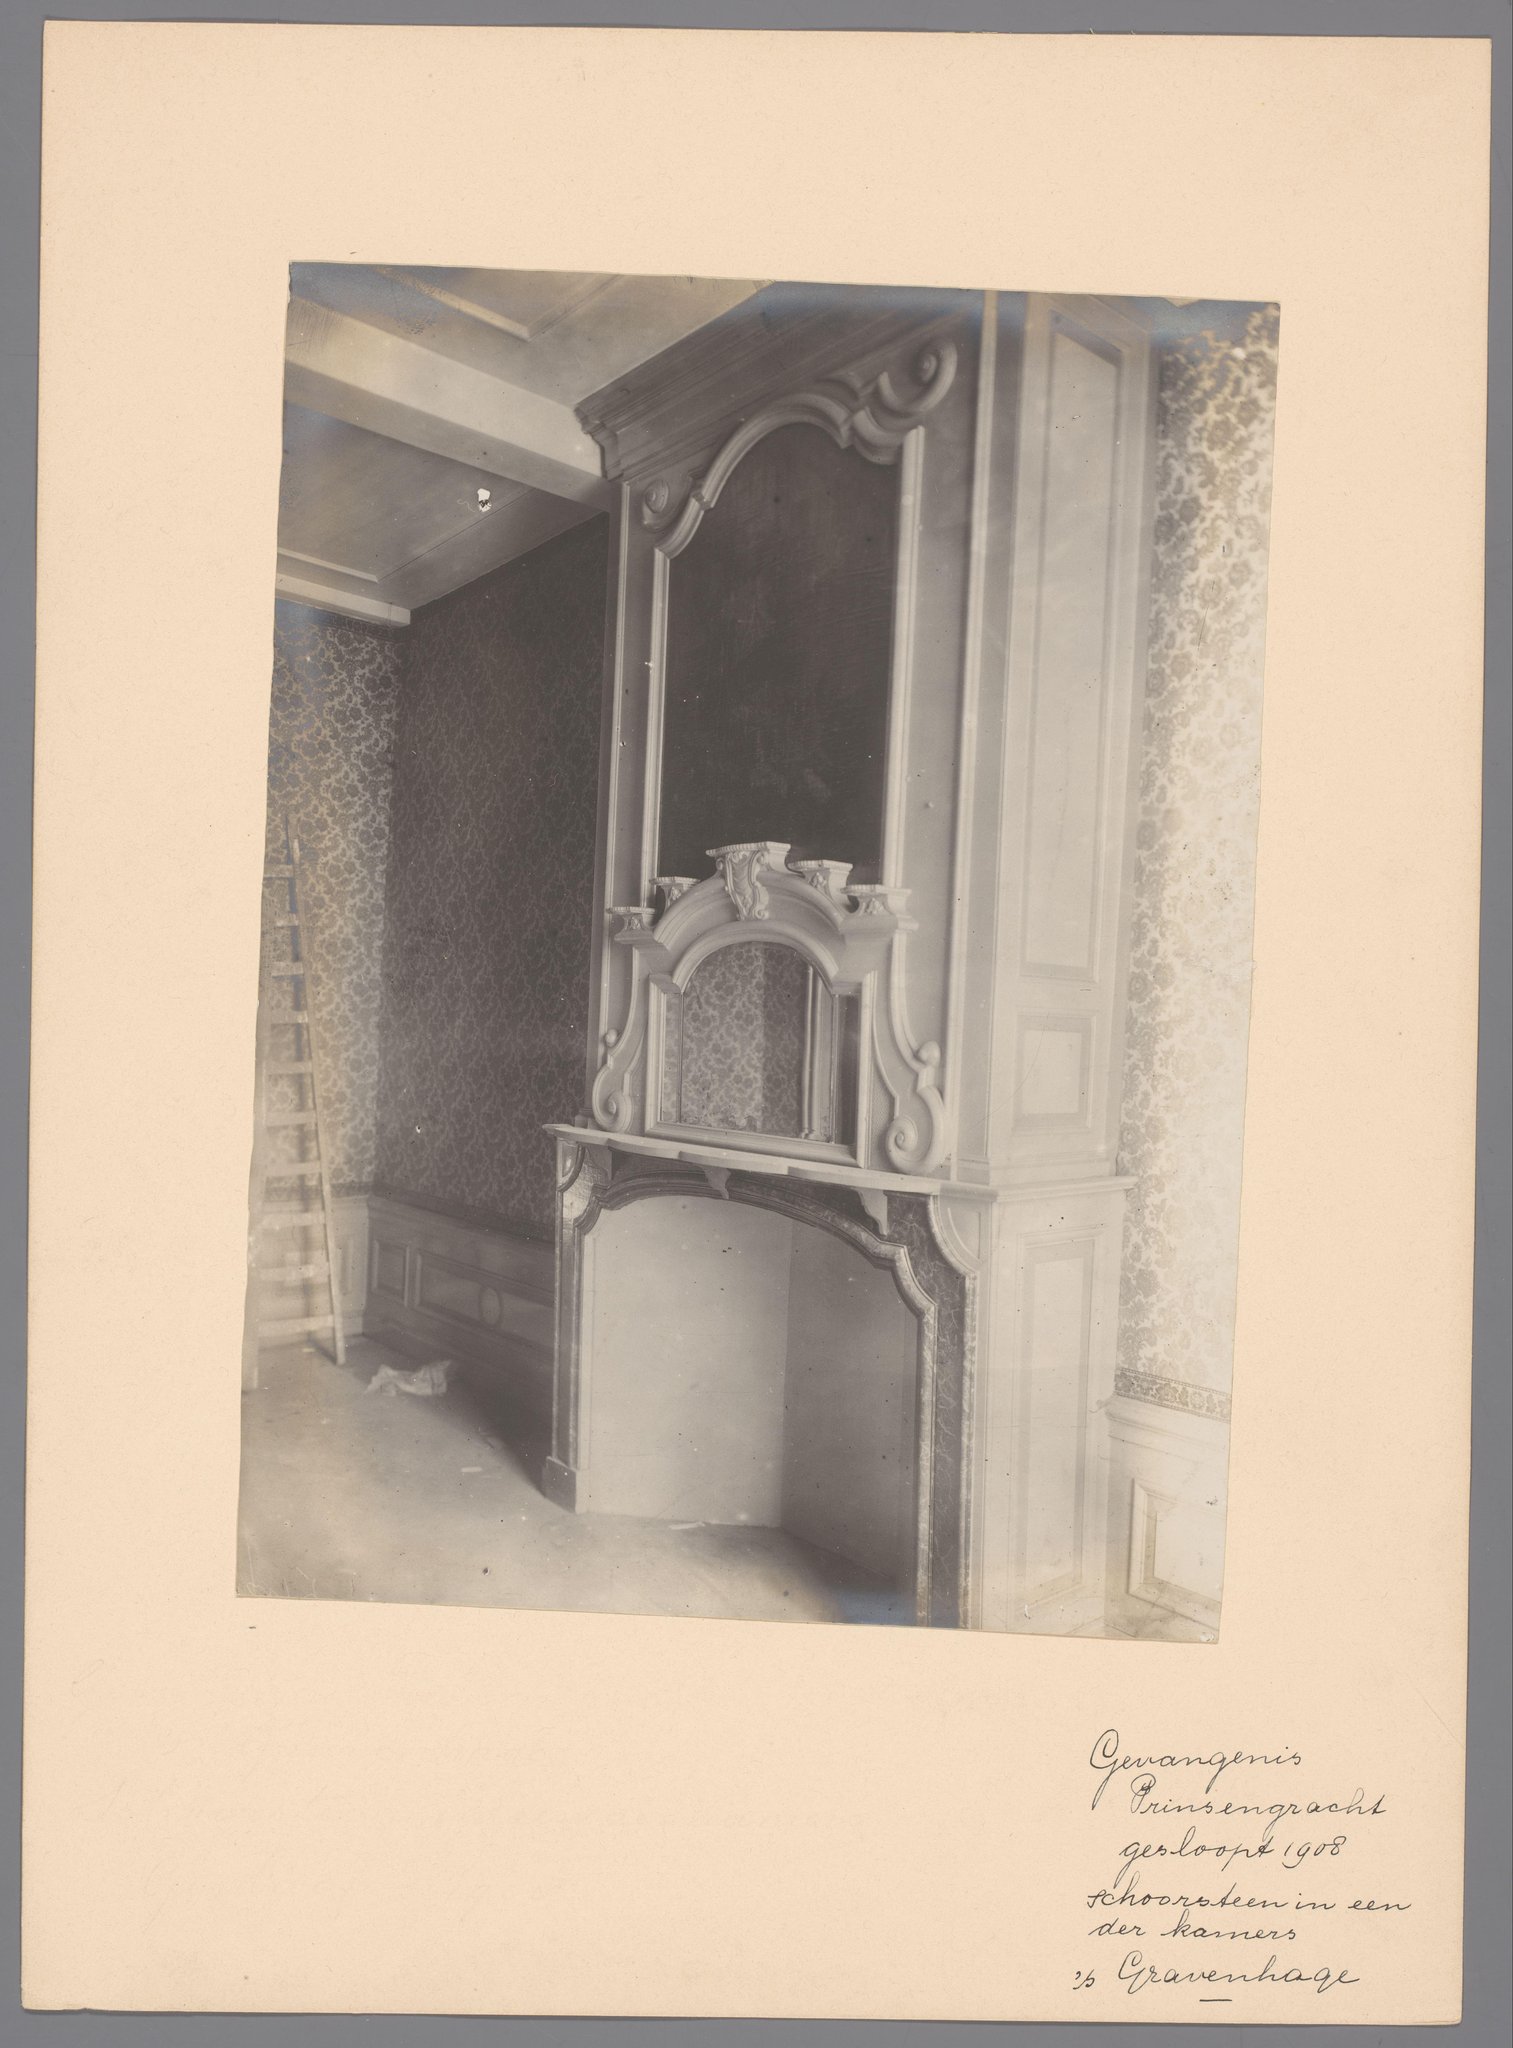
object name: photograph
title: Interieur met schoorsteen in de gevangenis op de Prinsegracht te Den Haag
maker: anoniem (monumentenzorg)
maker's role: fotograaf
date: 1900-1908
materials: cardboard, photographic support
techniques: gelatin silver print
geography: prinsegracht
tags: prison, jail, chimney-piece, mantelpiece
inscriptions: collector's mark: ‘R:MUS.’ Lugt 2228, annotation: ‘Gevangenis Prinsengracht gesloopt 1908/ schoorsteen in een der kamers/ 's Gravenhage’